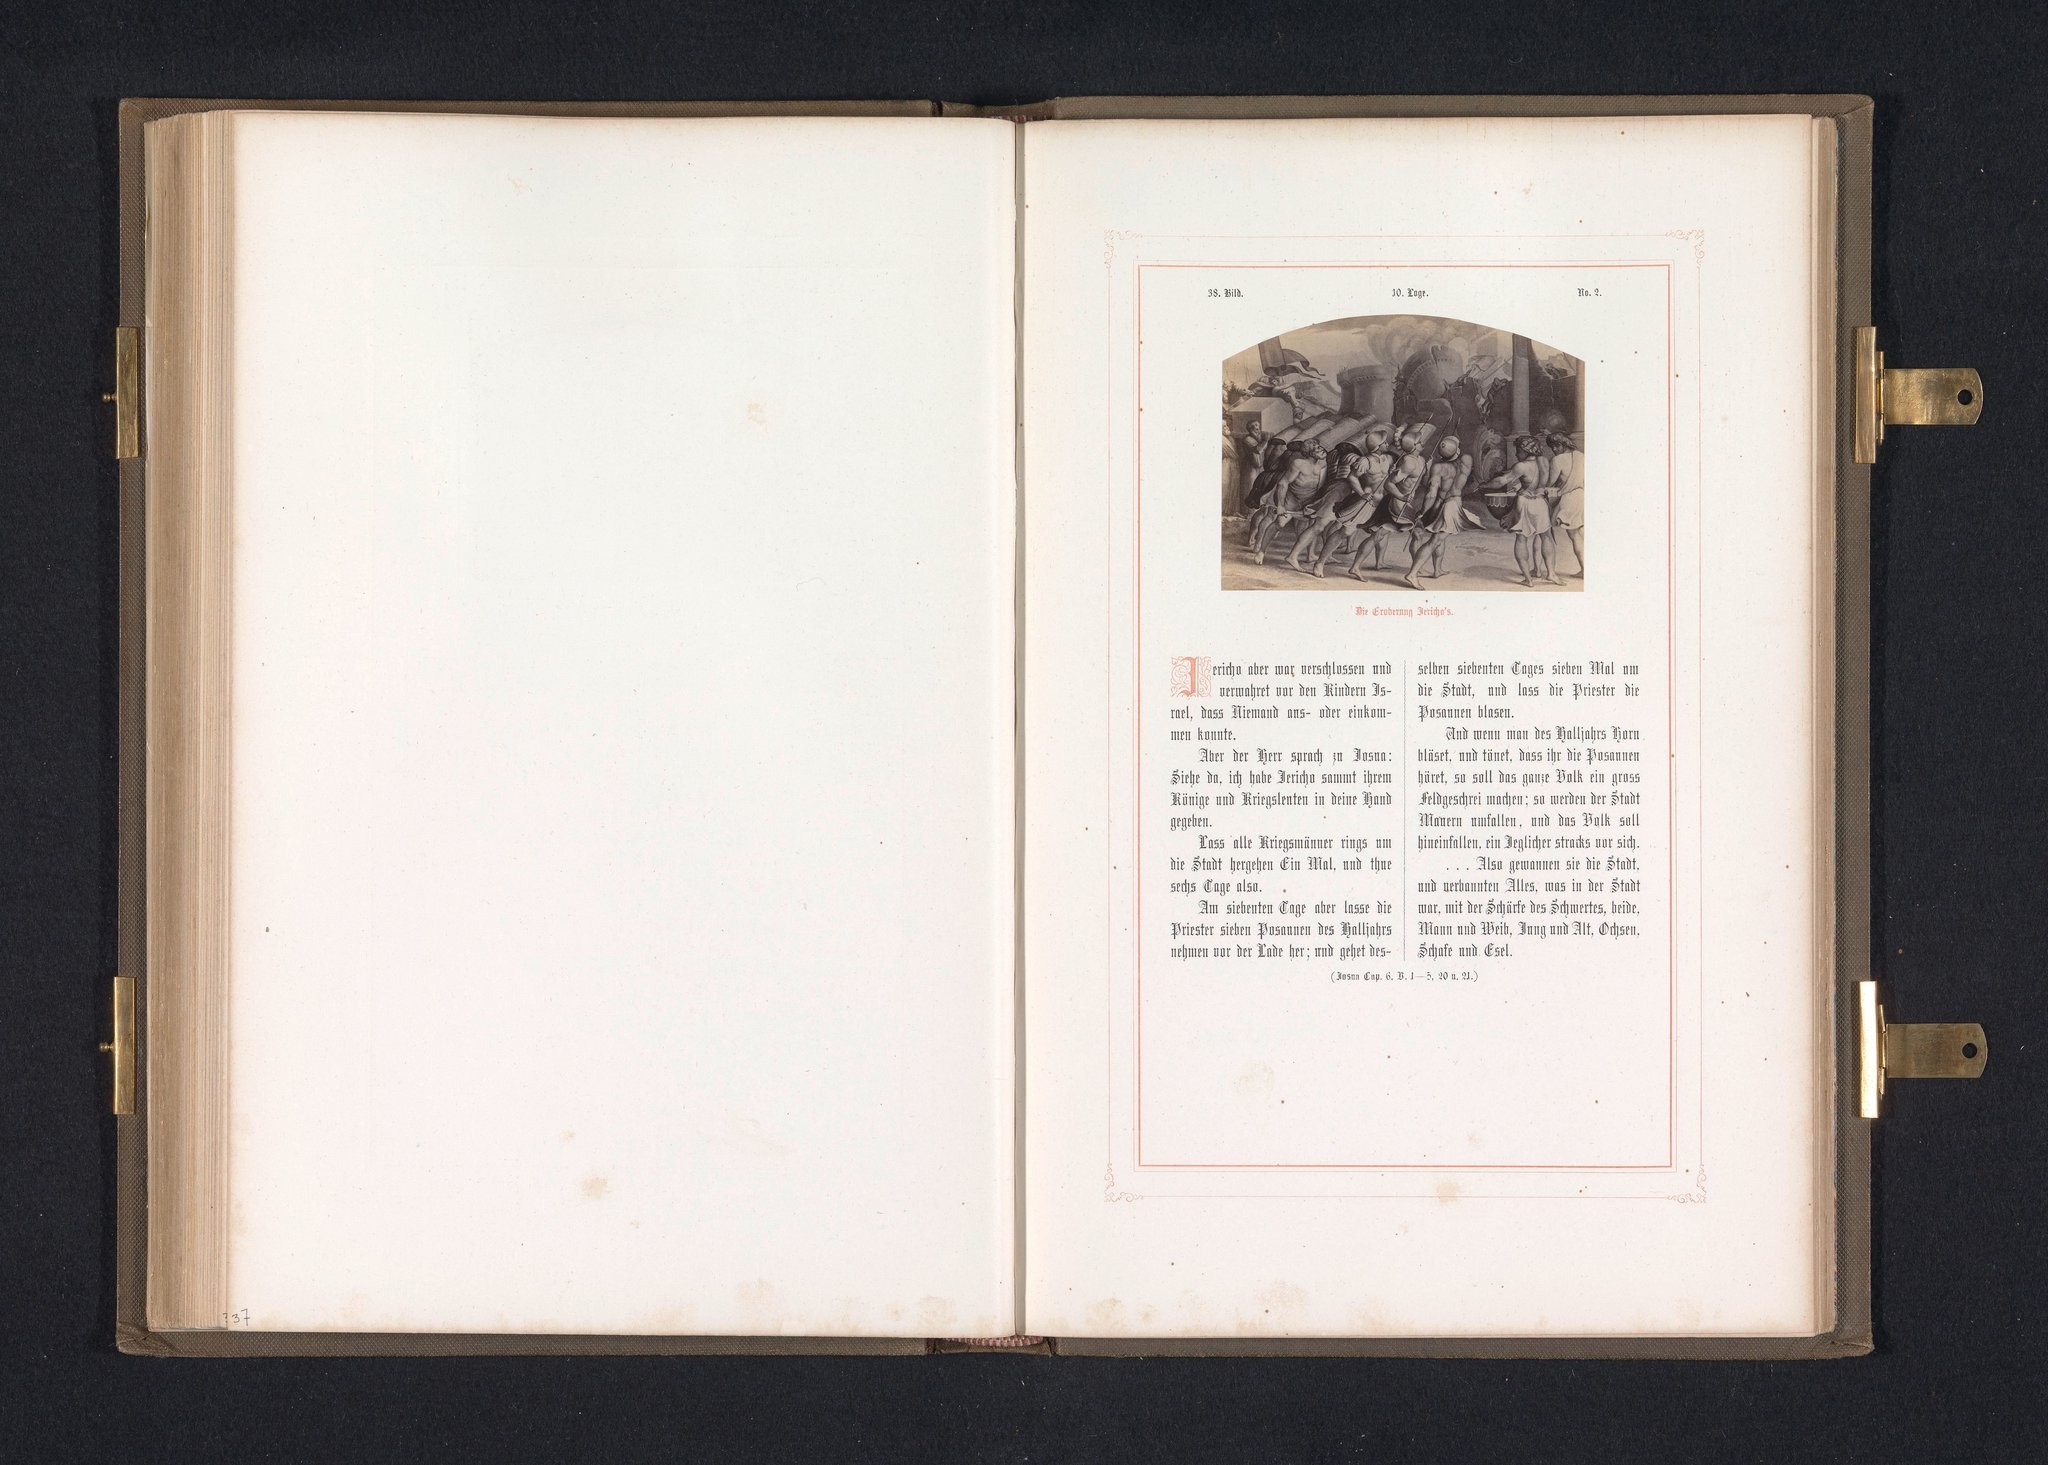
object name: photograph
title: Die Eroberung Jericho's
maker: gustav schauer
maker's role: painter, publisher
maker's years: 1826-1902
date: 1851-1861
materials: photographic support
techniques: albumen print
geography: berlin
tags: the fall of jericho (joshua 6)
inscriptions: inscription: ‘38. Bild. 10. Loge. No. 2.’